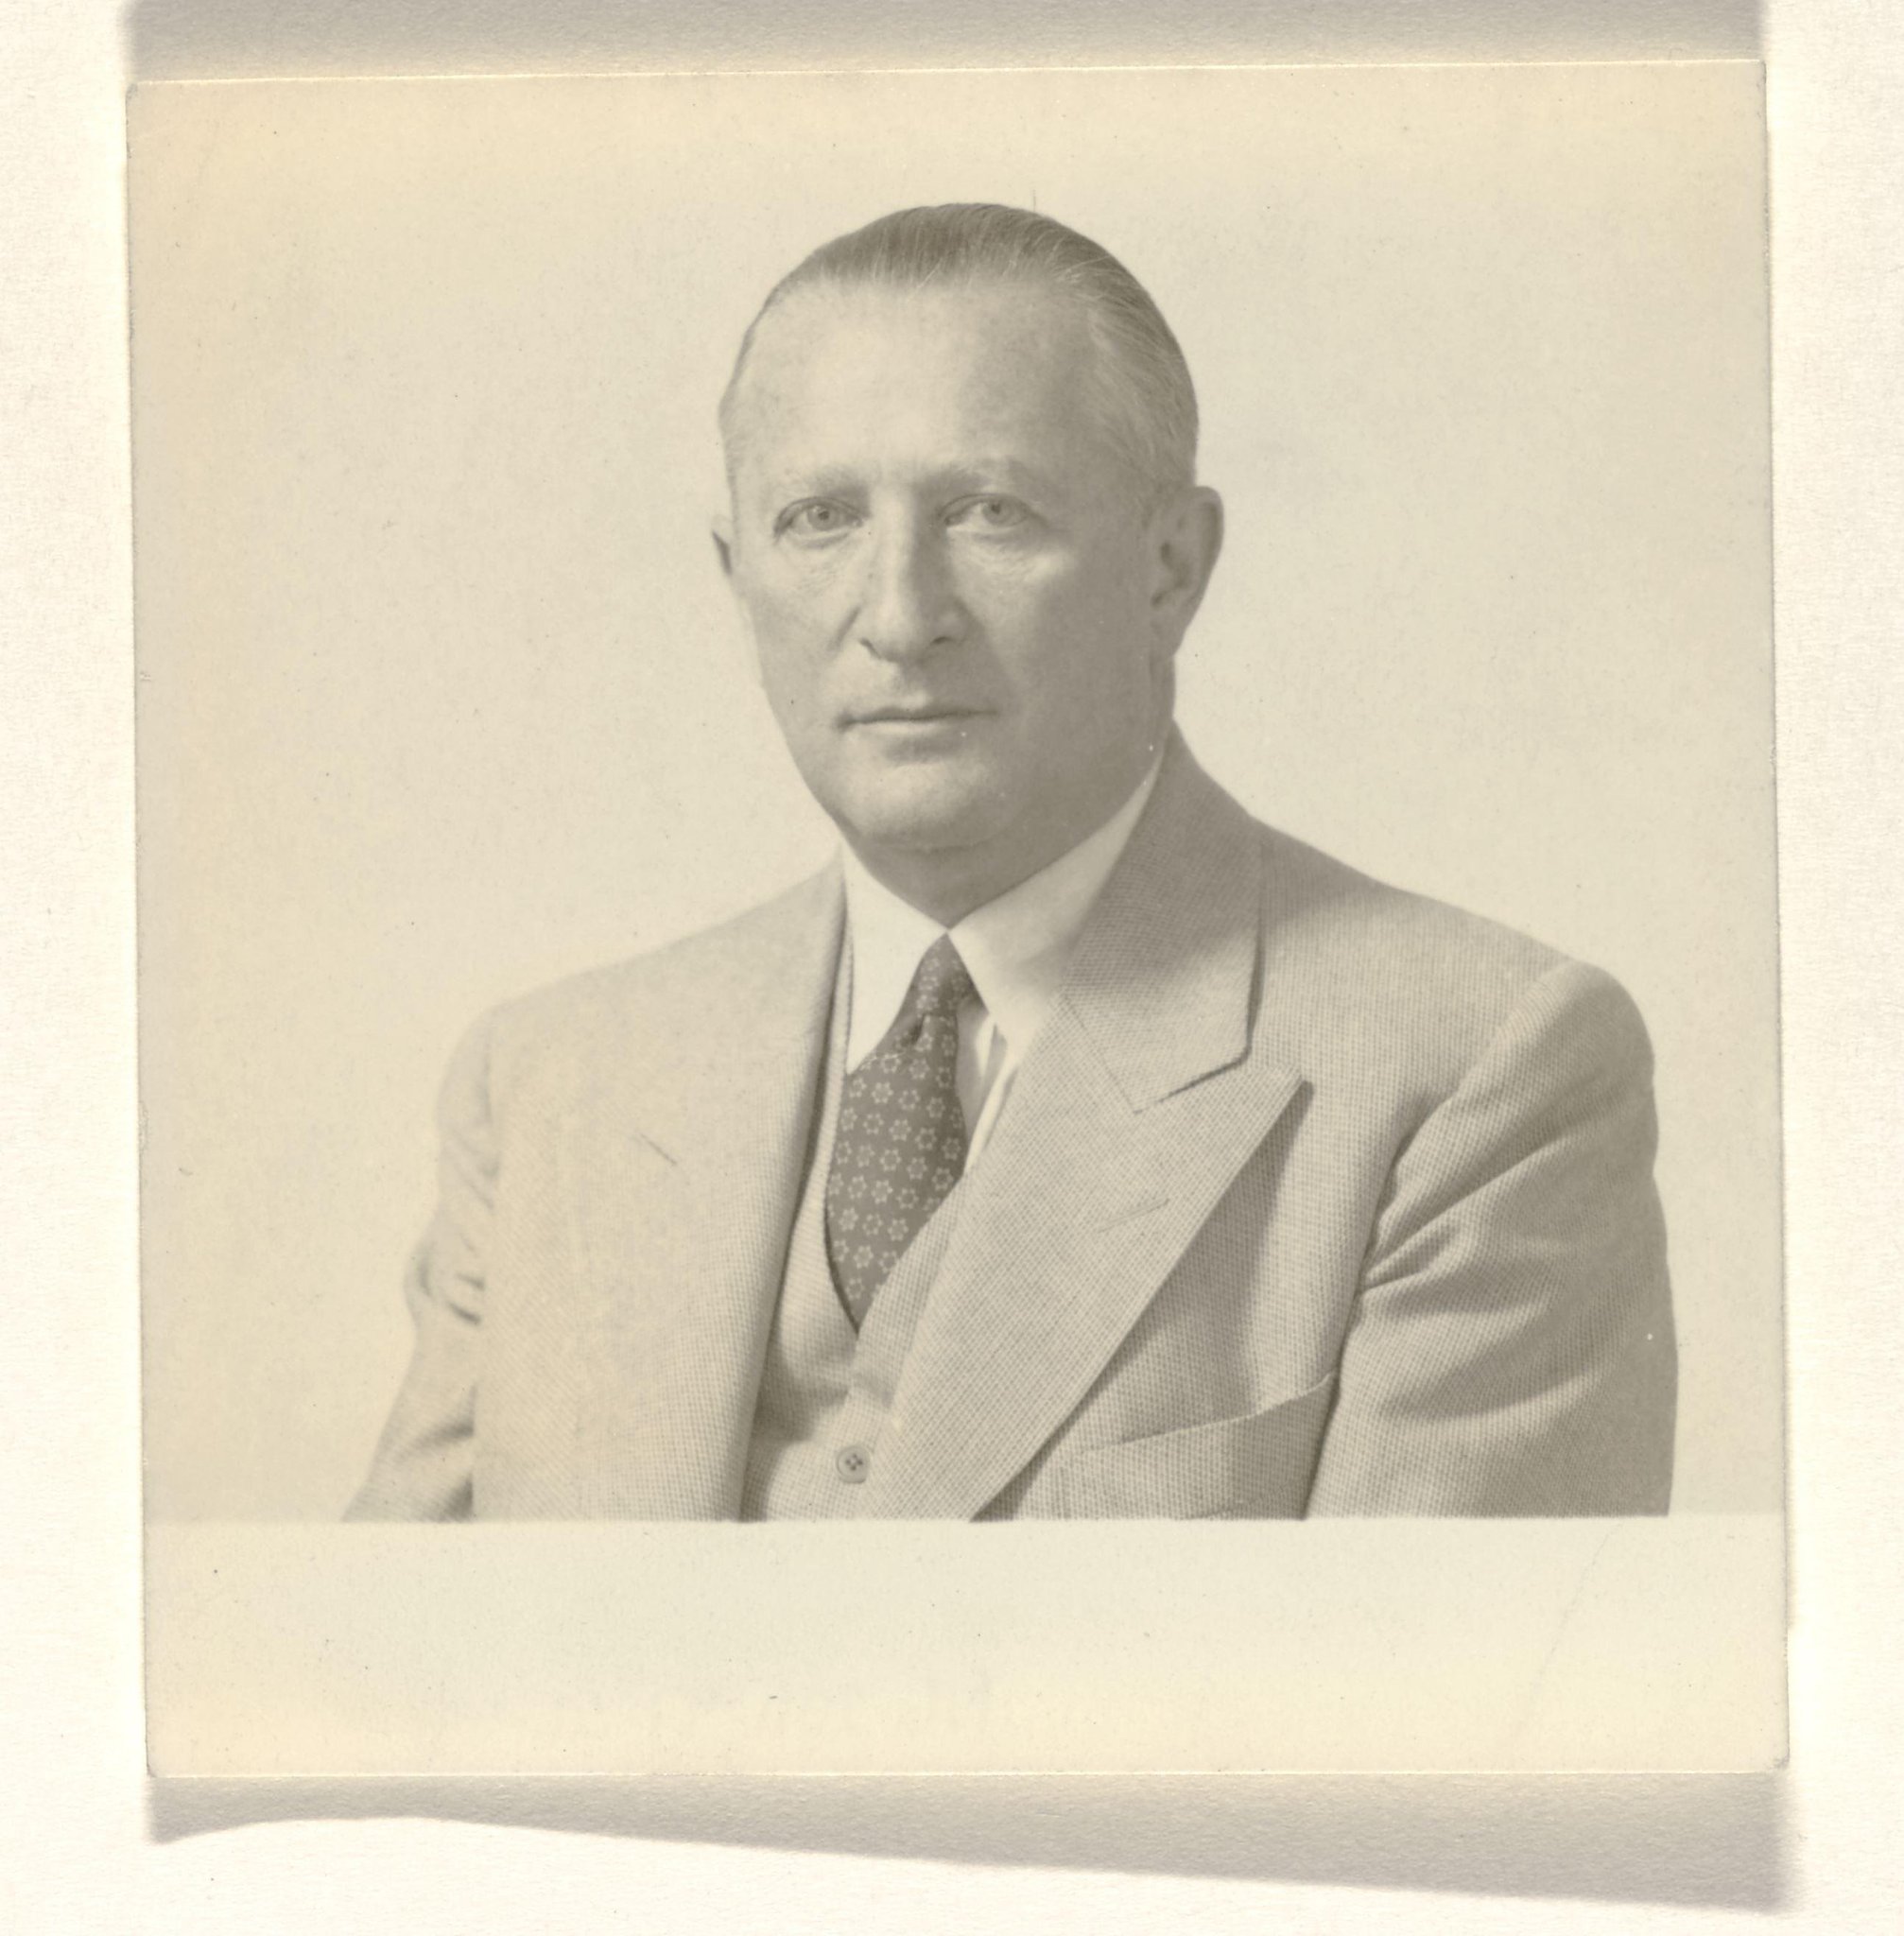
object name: photograph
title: Portret van Willy Moos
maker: Anonymous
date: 1902-1954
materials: photographic support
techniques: gelatin silver print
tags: willy moos, new york (city)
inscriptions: inscription: ‘Underhill Studio 17 Park Place New York .../2/54’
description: Portret van Willy Moos in pak met gestipte das.